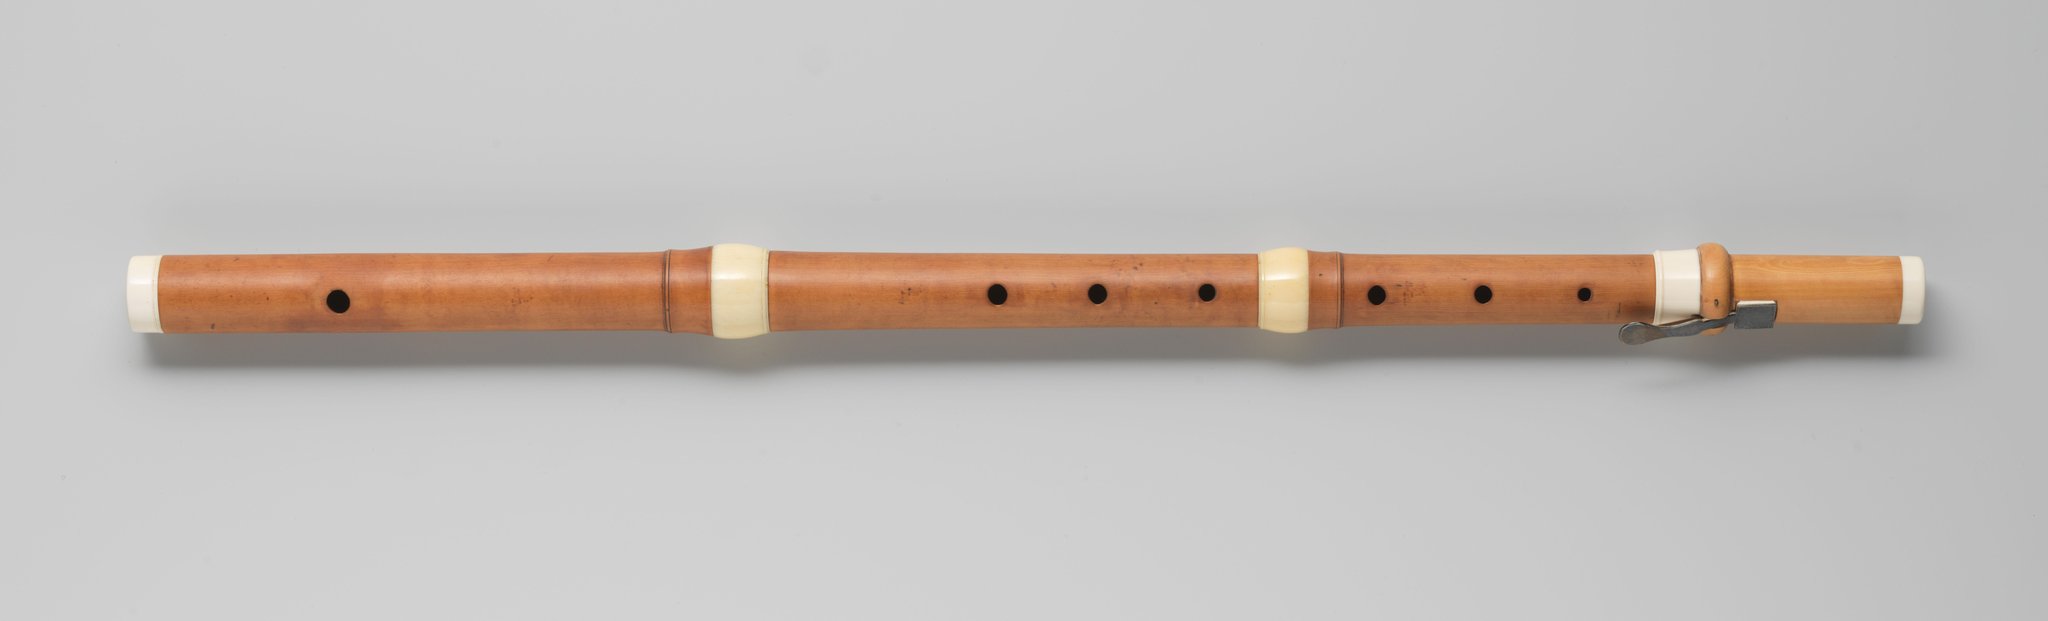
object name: wind instrument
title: Flute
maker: thomas lot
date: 1734-1755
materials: wood, ivory, silver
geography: europe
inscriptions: stamp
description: Vierdelige dwarsfluit van buxushout met ringen van ivoor en een zilver klep. Deze traverso is gemaakt in een lage Franse barokstemming (a< 400 Hz) en heeft als opvallend kenmerkt dat mond- en vingergaten in dwarsrichting een grotere diameter hebben dan in lengterichting. De voet is een moderne reconstructie als vervanging voor het verdwenen originele exemplaar. Stempel: T*LOT / [ongebreidelde leeuw] (op kop, boverste en onderste middendeel).